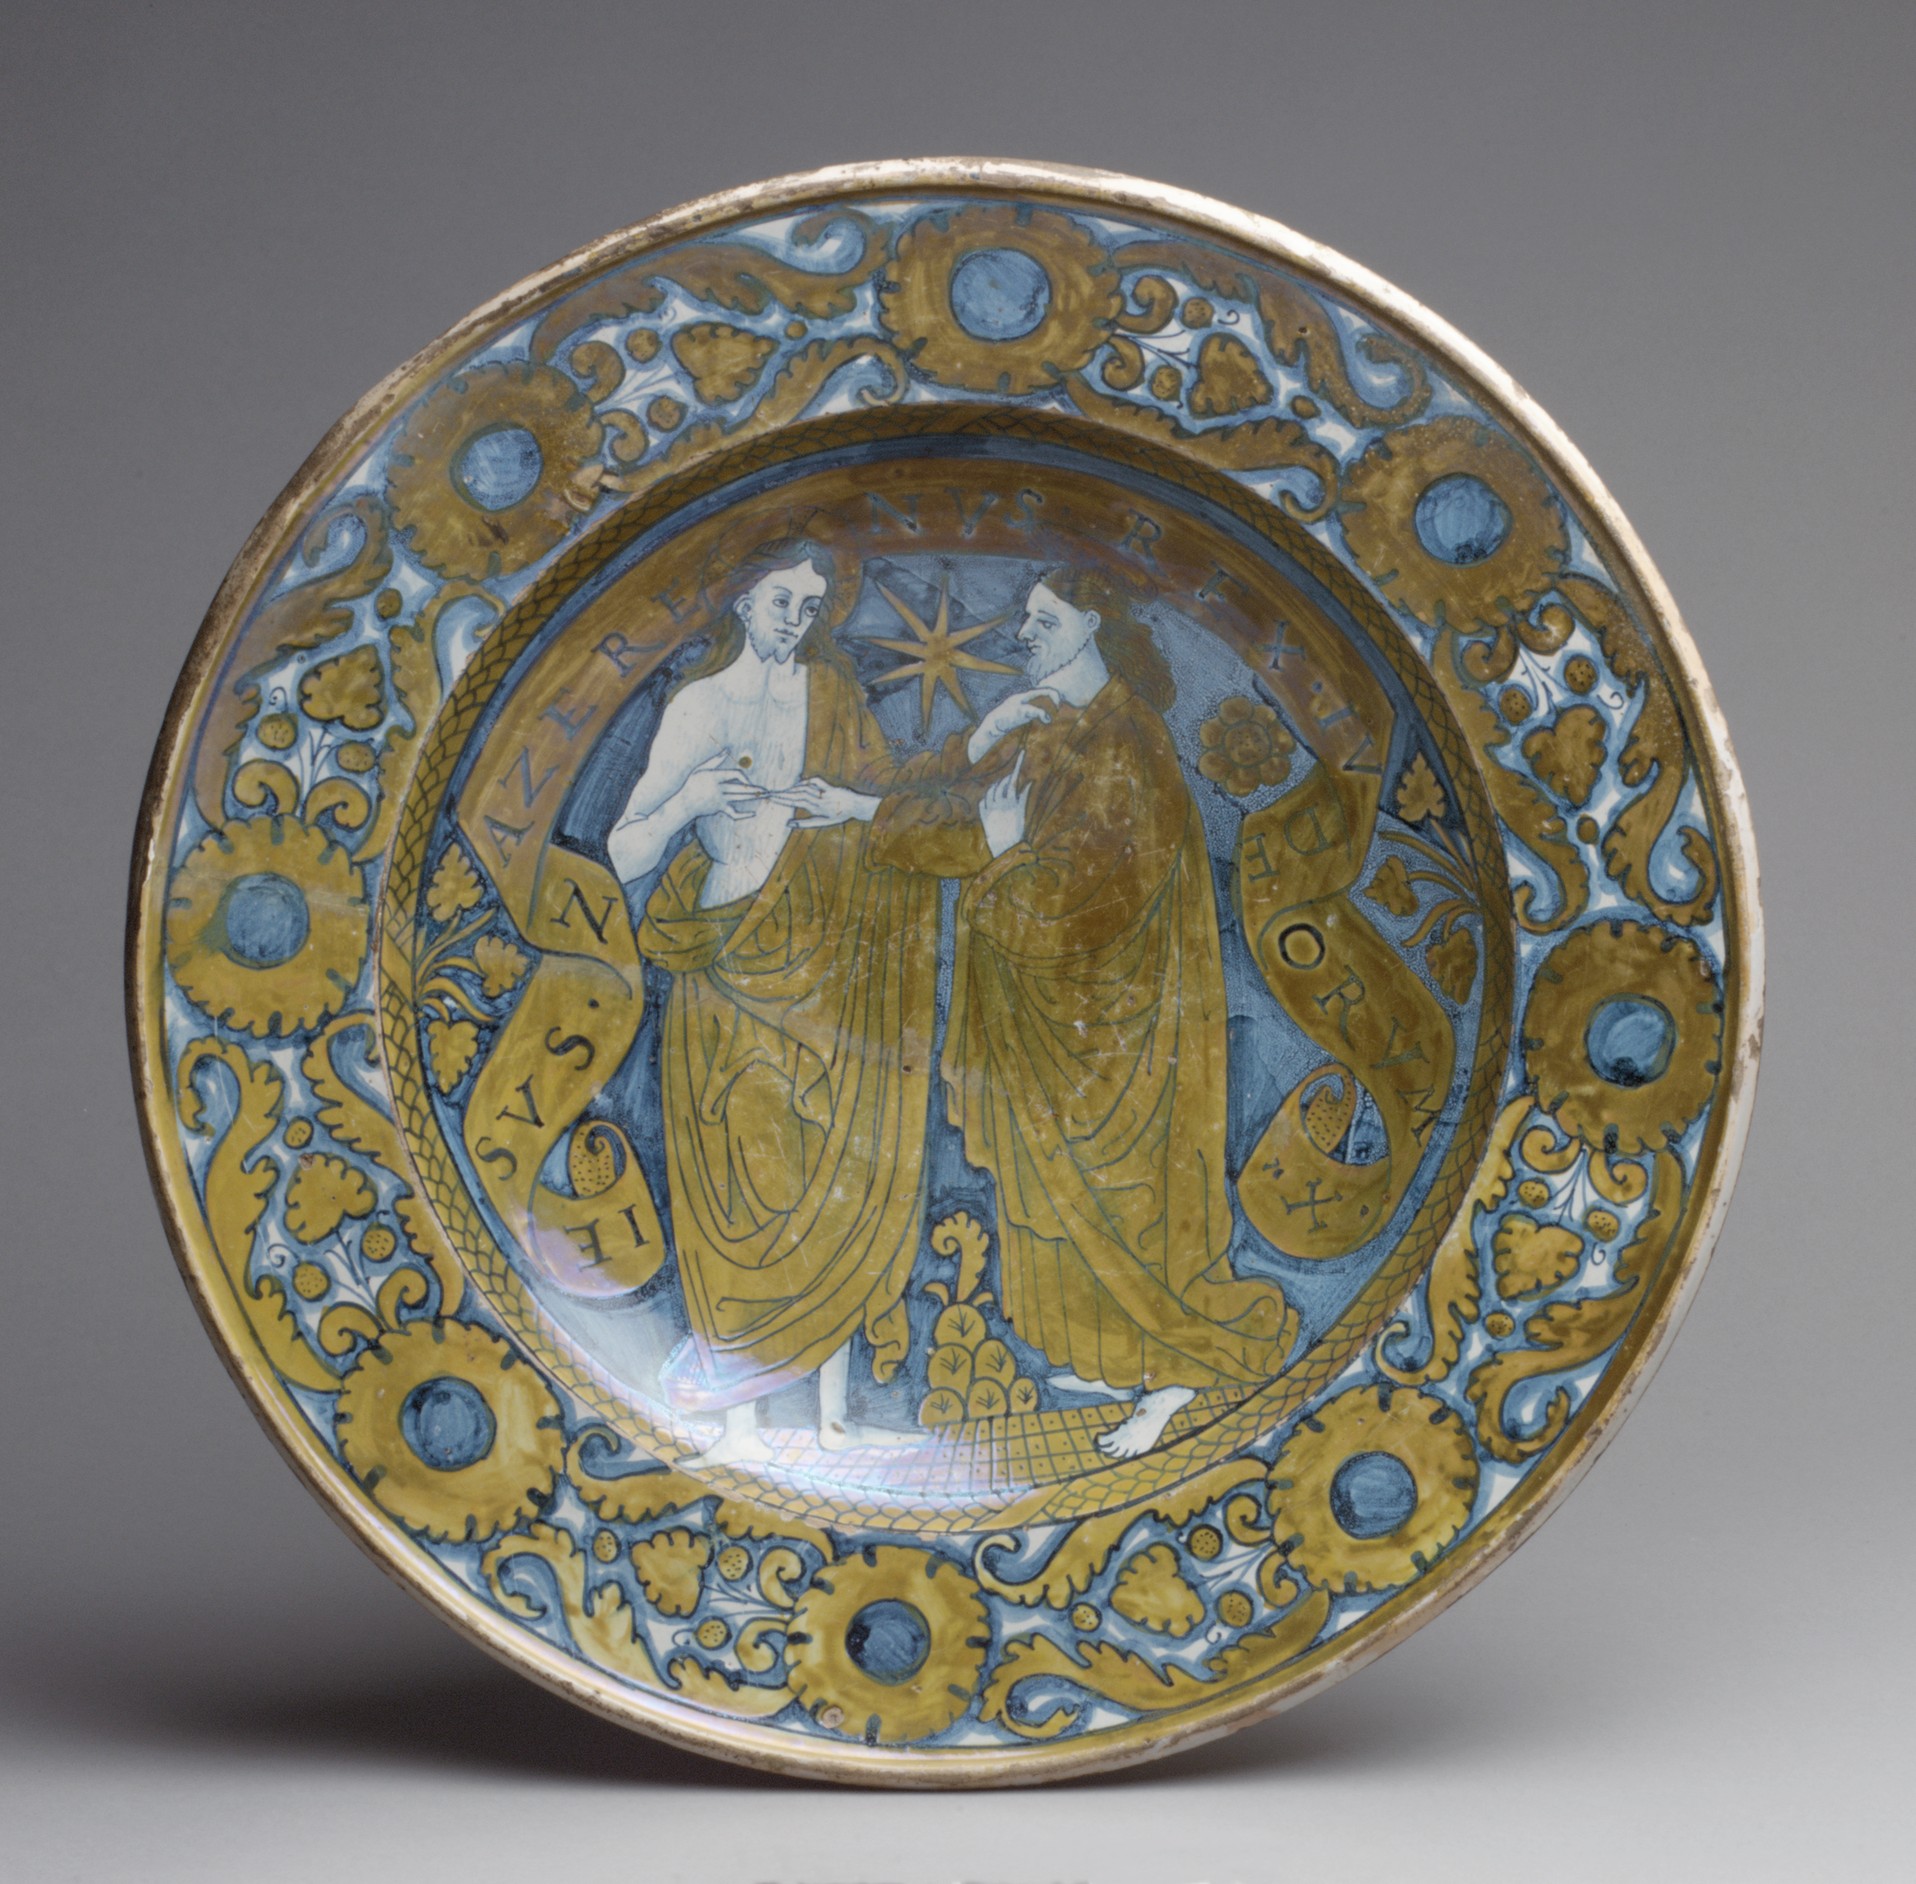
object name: dish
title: Dish with the Incredulity of St. Thomas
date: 1520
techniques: maiolica, glazing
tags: men,saints